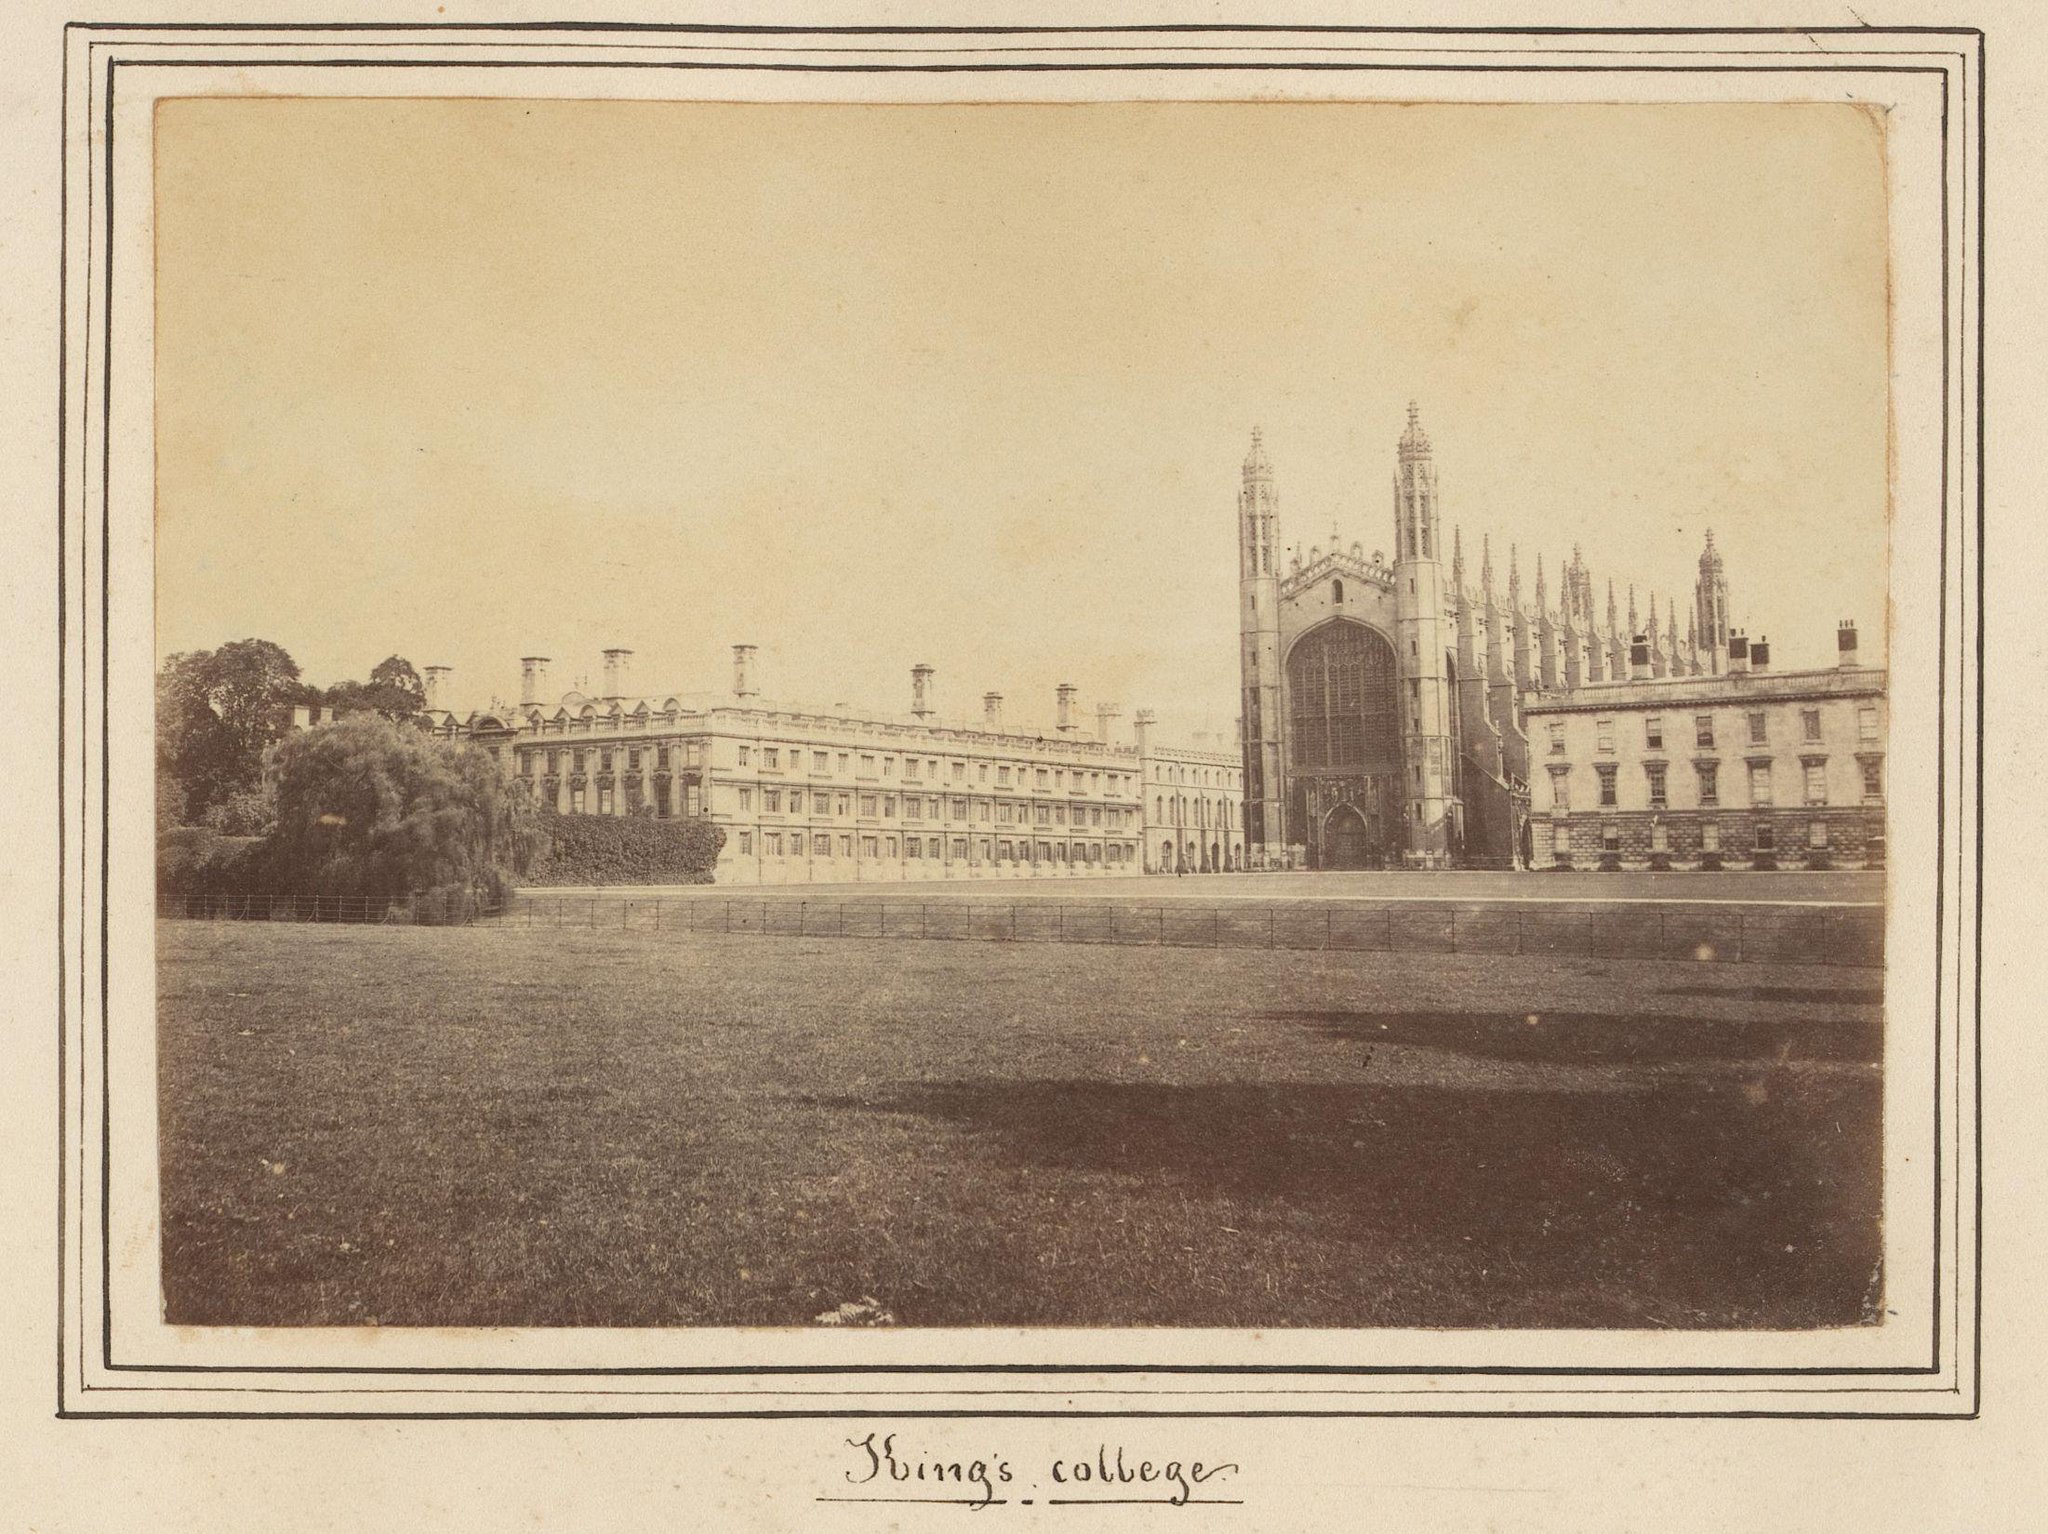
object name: photograph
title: Gezicht op de kapel van King's College, Cambridge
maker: Anonymous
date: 1865-1890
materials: paper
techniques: albumen print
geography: cambridge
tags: university building, college, church (exterior) - qq - small church, chapel